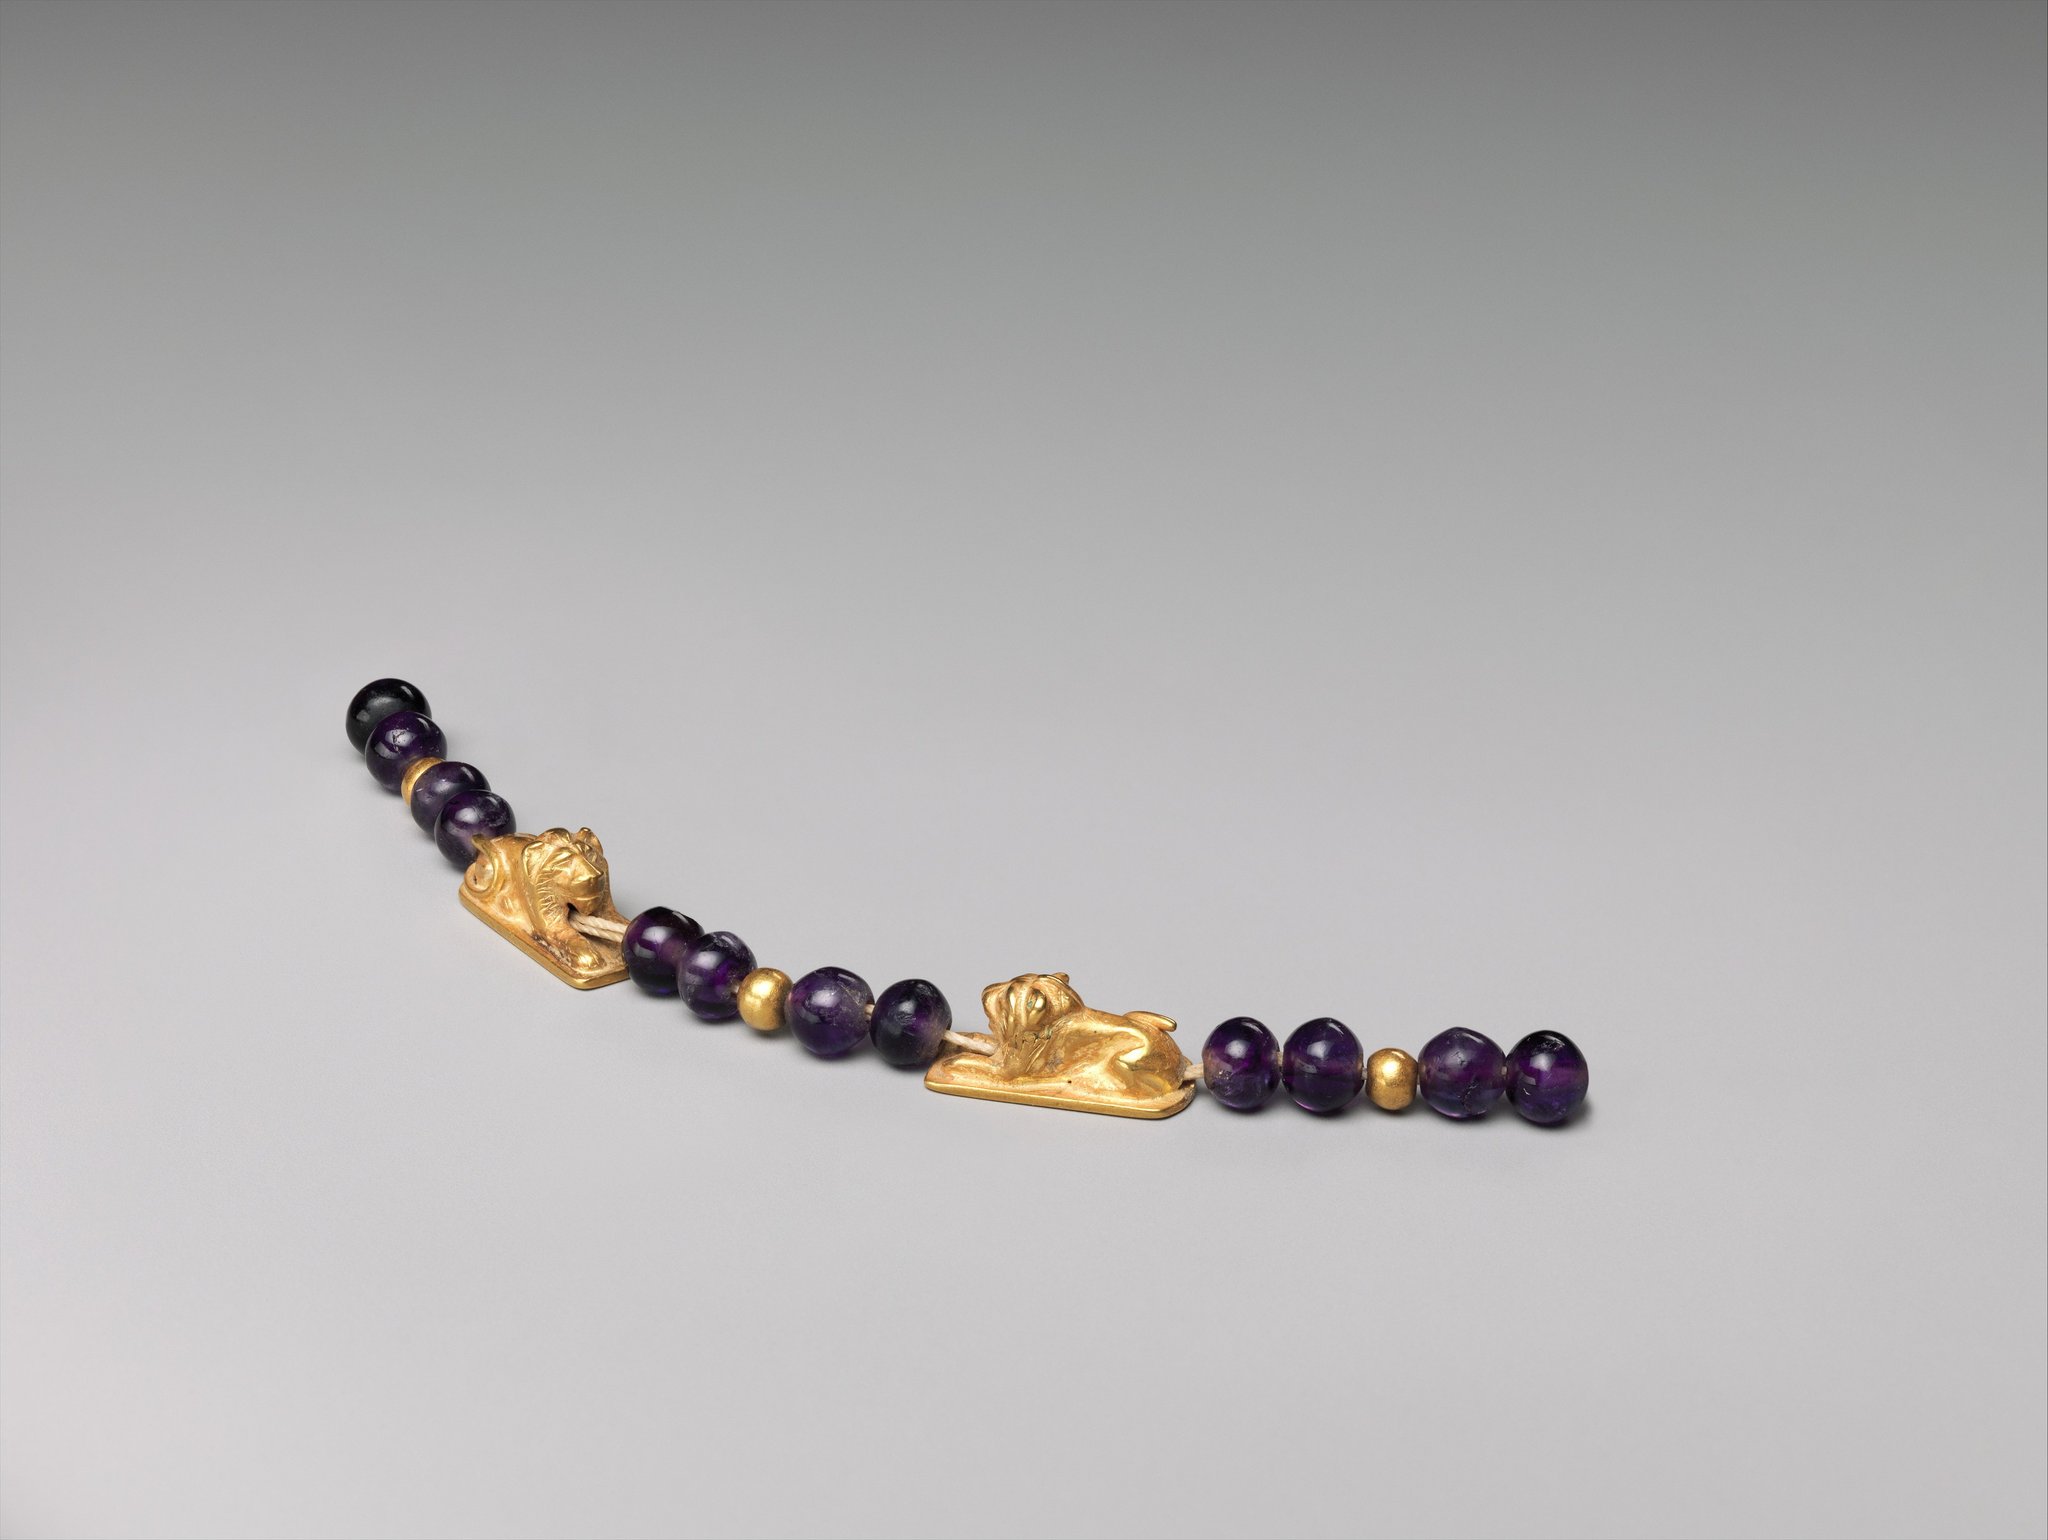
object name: bracelet, sithathoryunet, lion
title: Lion Bracelet of Sithathoryunet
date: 1887-1813 BCE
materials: gemstone, gold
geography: egypt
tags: lions